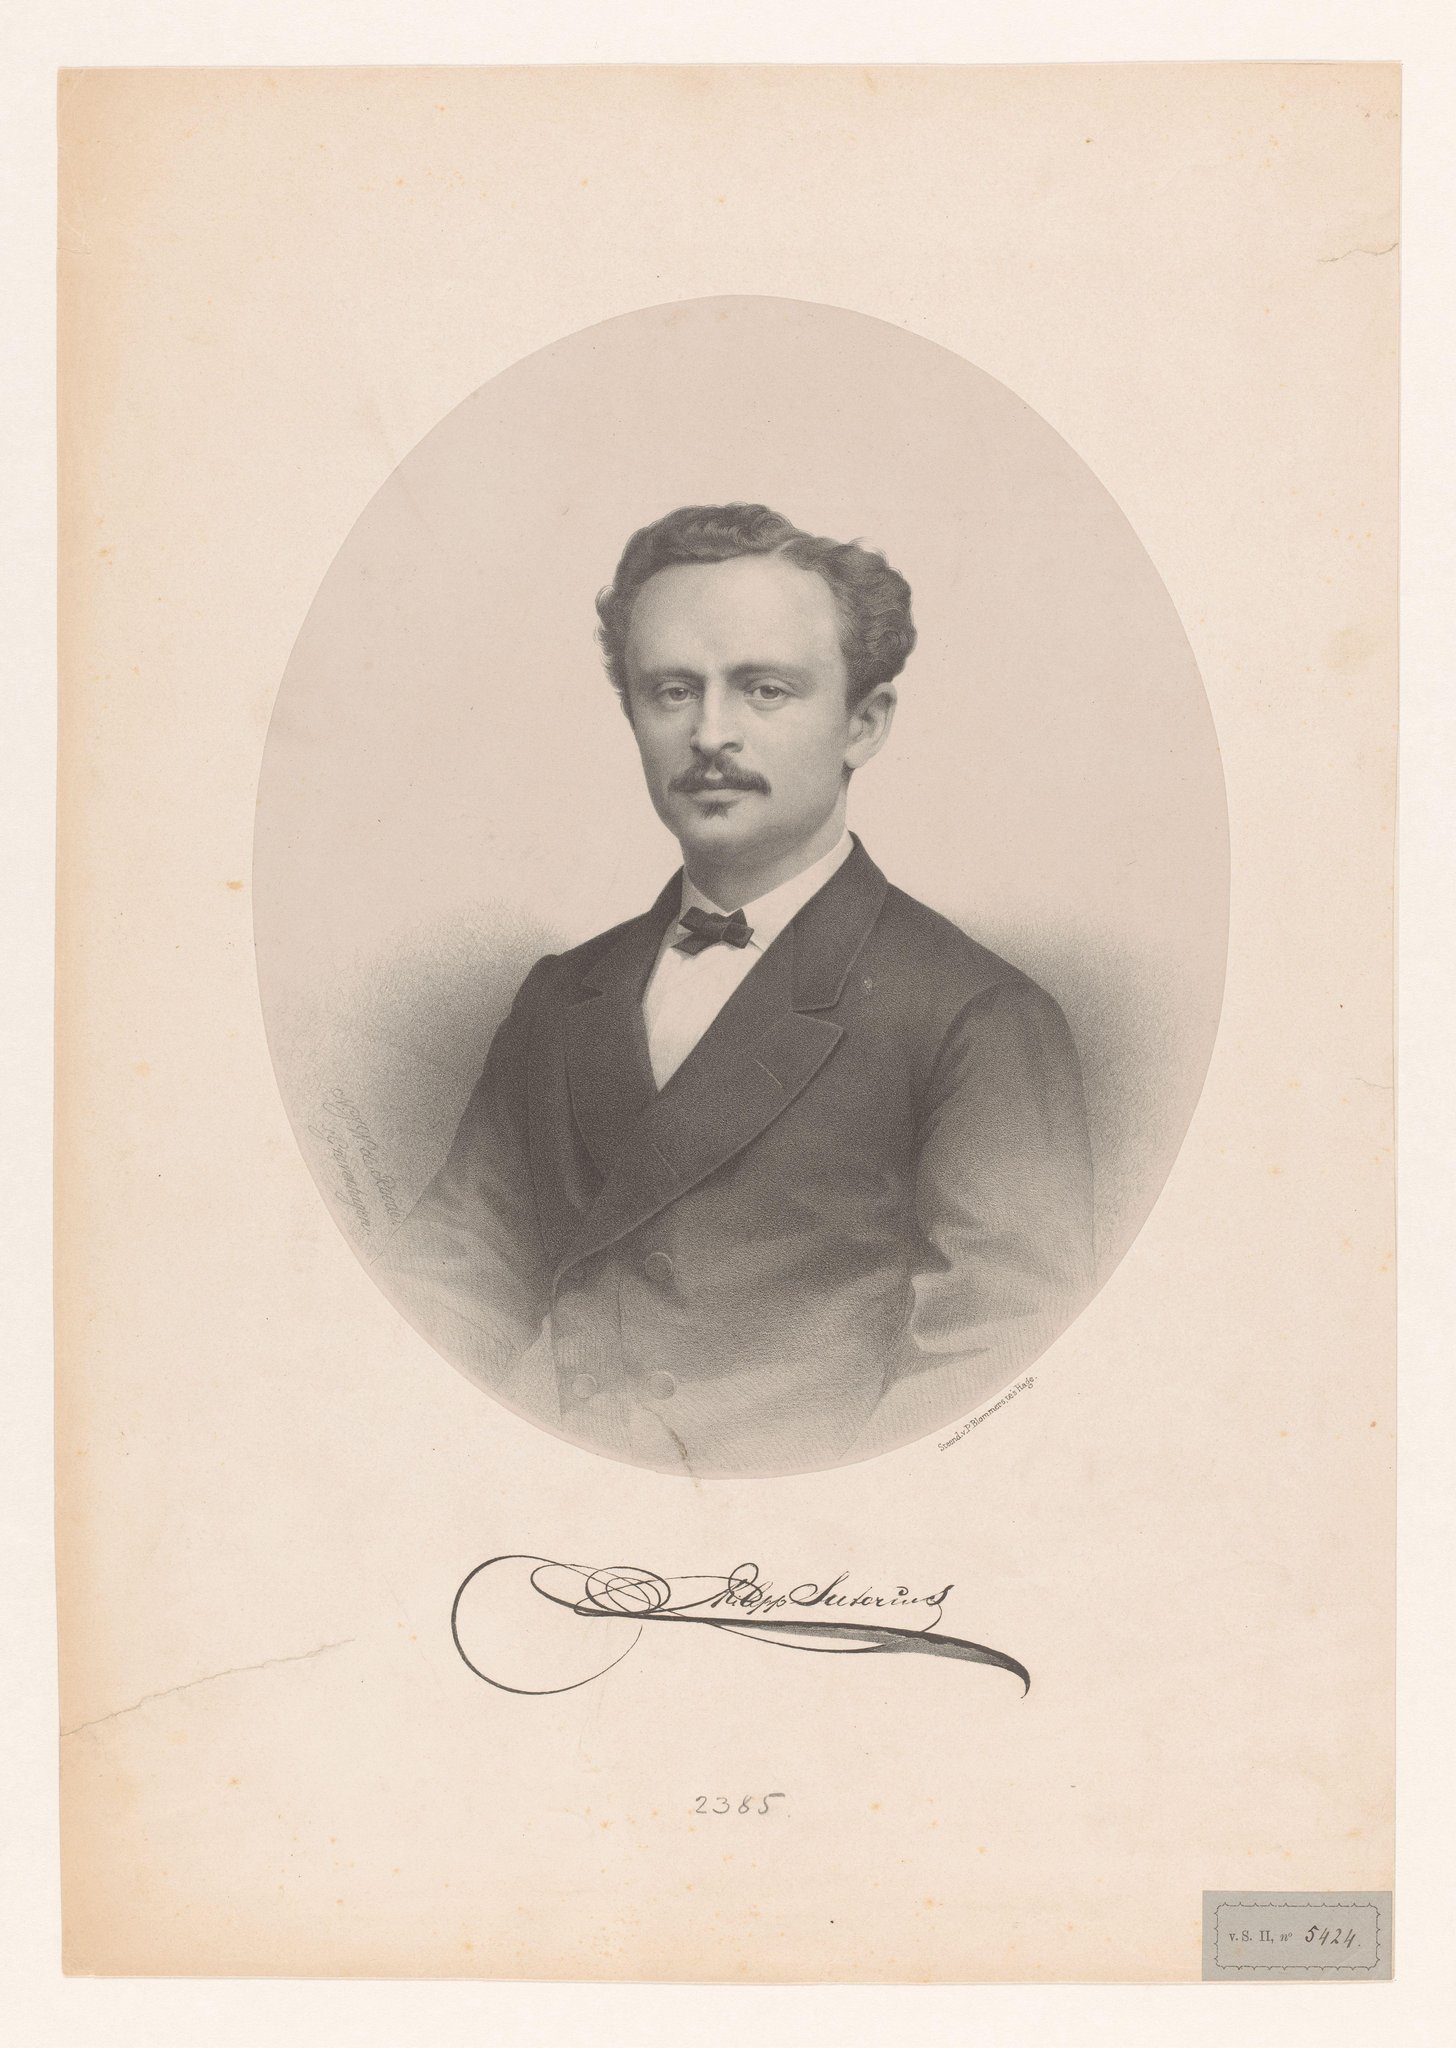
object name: print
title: Portret van Philipp Sutorius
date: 1842-1887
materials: paper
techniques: lithograph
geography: the hague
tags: historical persons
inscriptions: collector's mark: Lugt 2228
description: Onder het portret de signatuur van de geportretteerde.